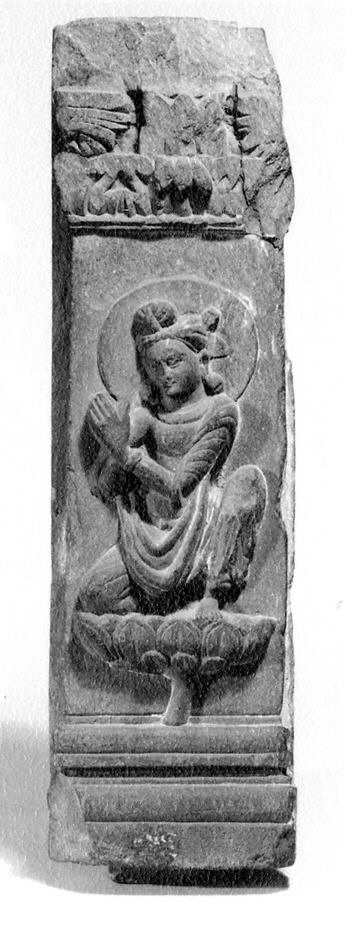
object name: sculpture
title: Kneeling Bodhisattva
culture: gandhara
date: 1-300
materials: stone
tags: gandhara,buddhism,bodhisattvas